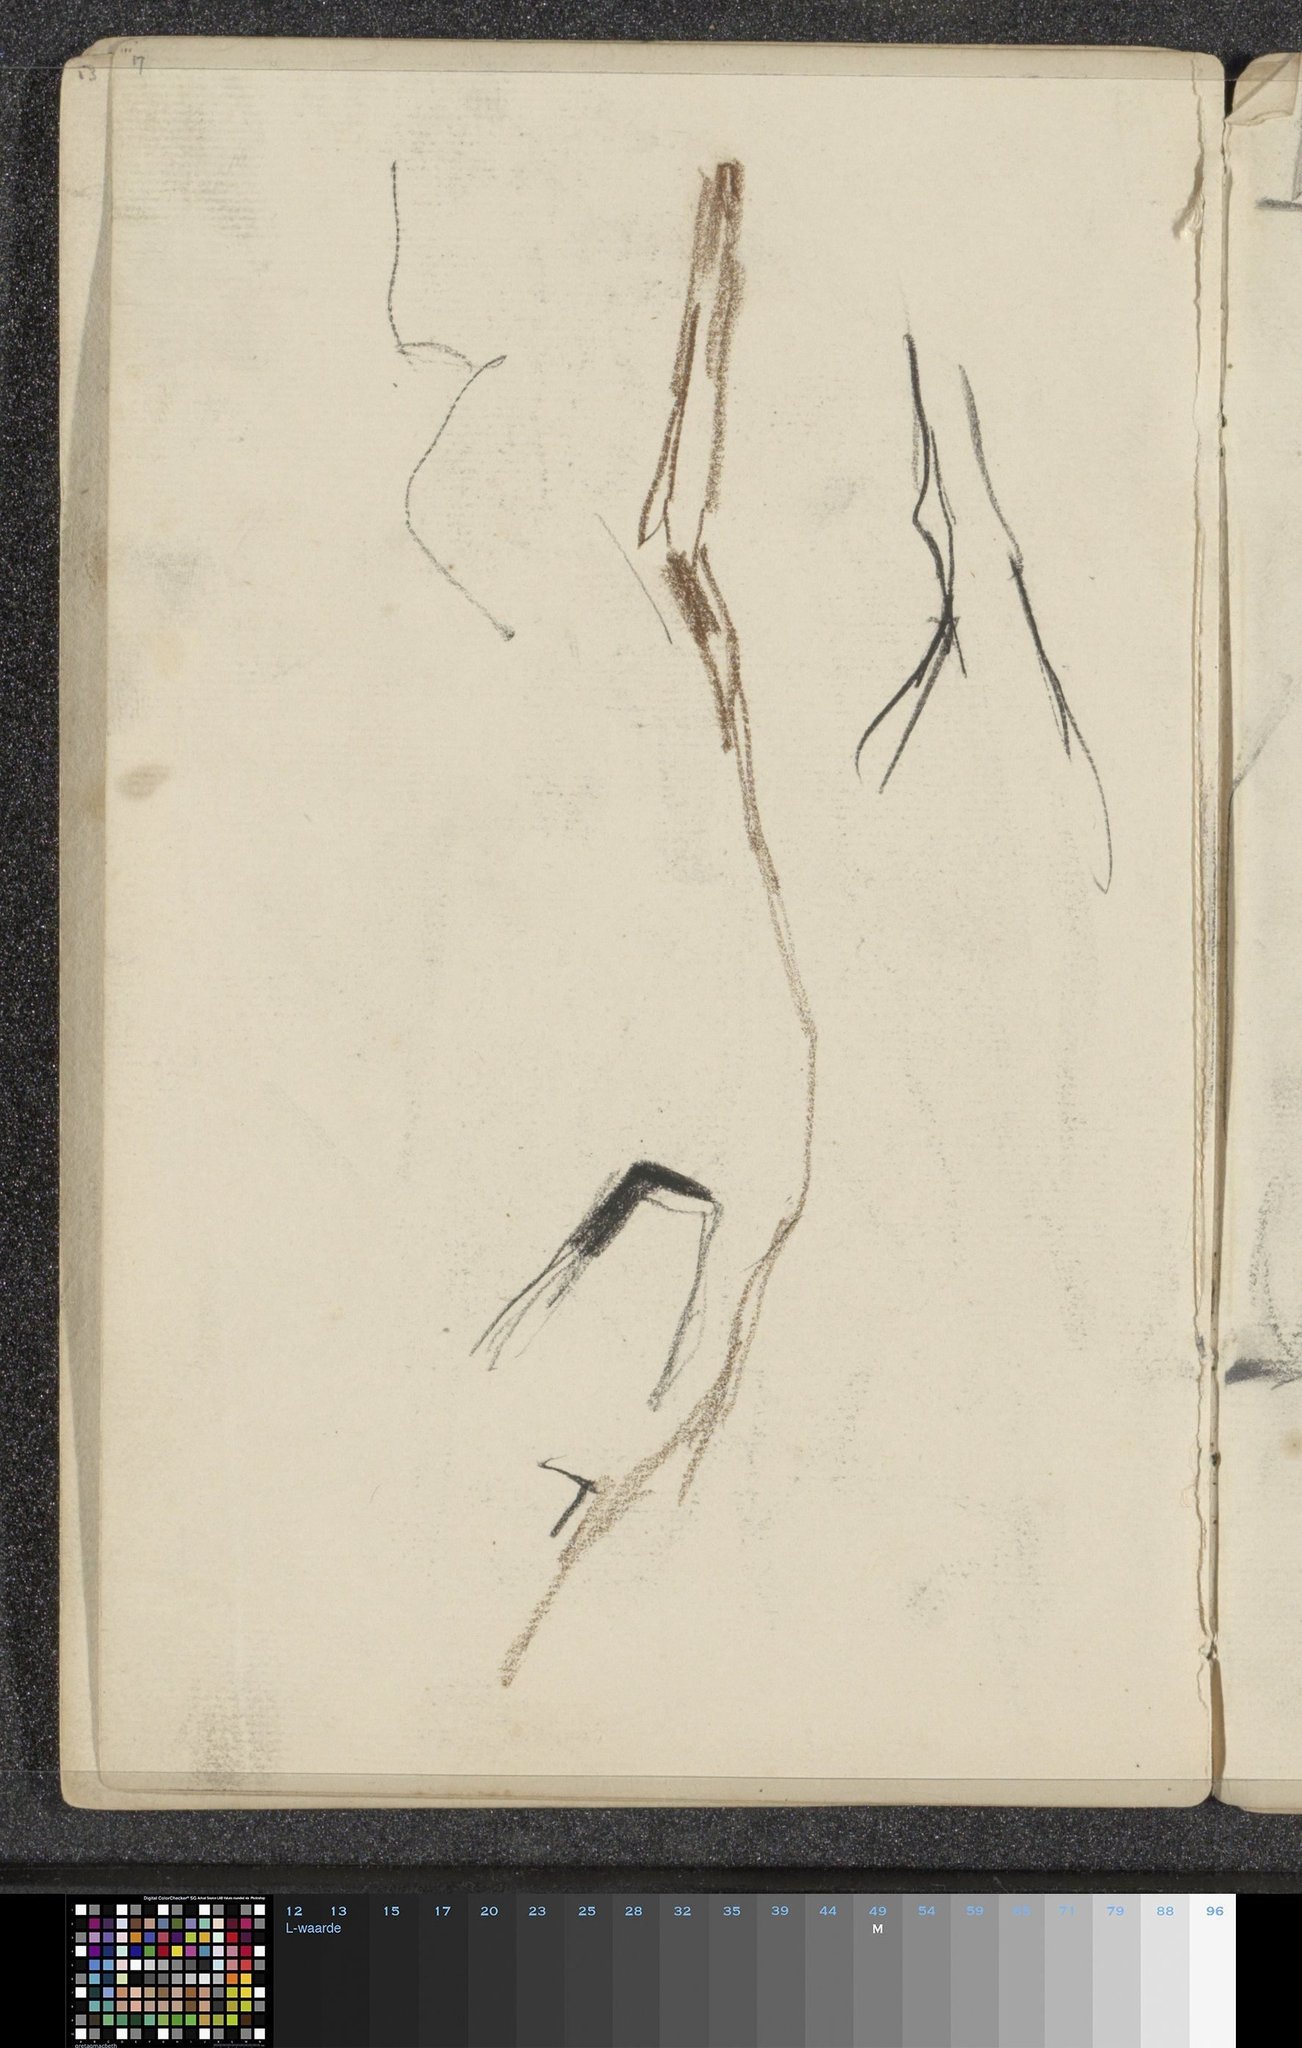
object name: sketchbook leaf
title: Paardenbenen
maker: george hendrik breitner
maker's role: draughtsman, painter, print maker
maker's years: 1857-1923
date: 1887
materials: chalk, paper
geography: amsterdam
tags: horse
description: Pagina 17 uit een schetsboek met 12 bladen.